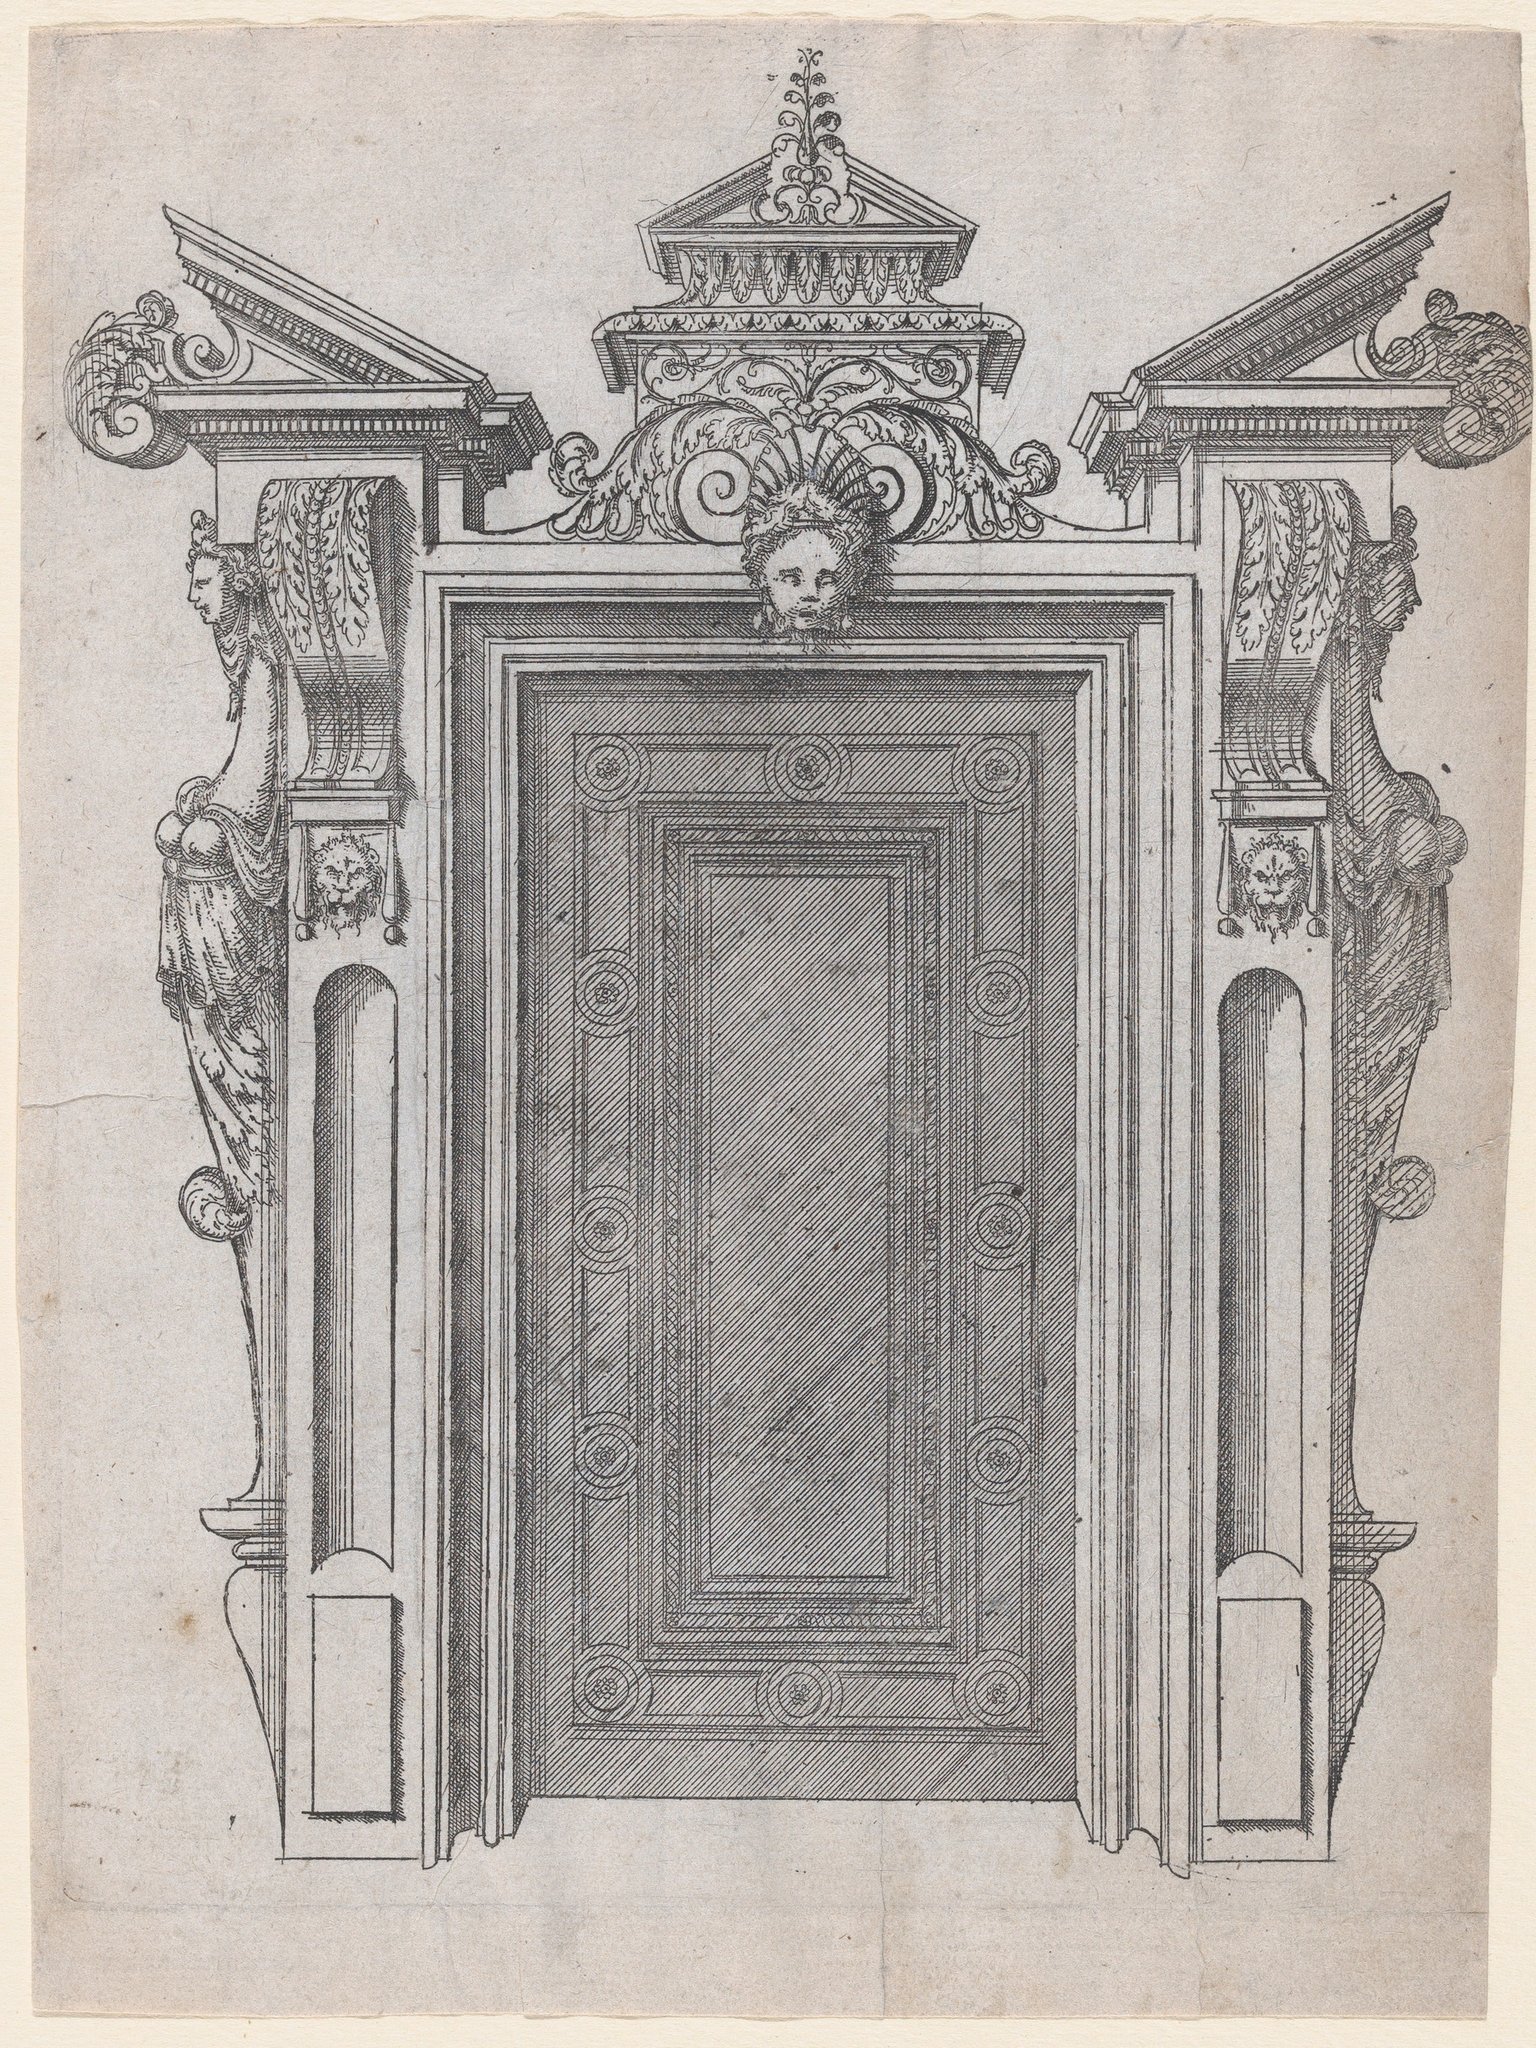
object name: print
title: Design for a Door Frame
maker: jacques androuet du cerceau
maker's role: artist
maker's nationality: french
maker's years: 1510-1585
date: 1565-1570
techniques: etching